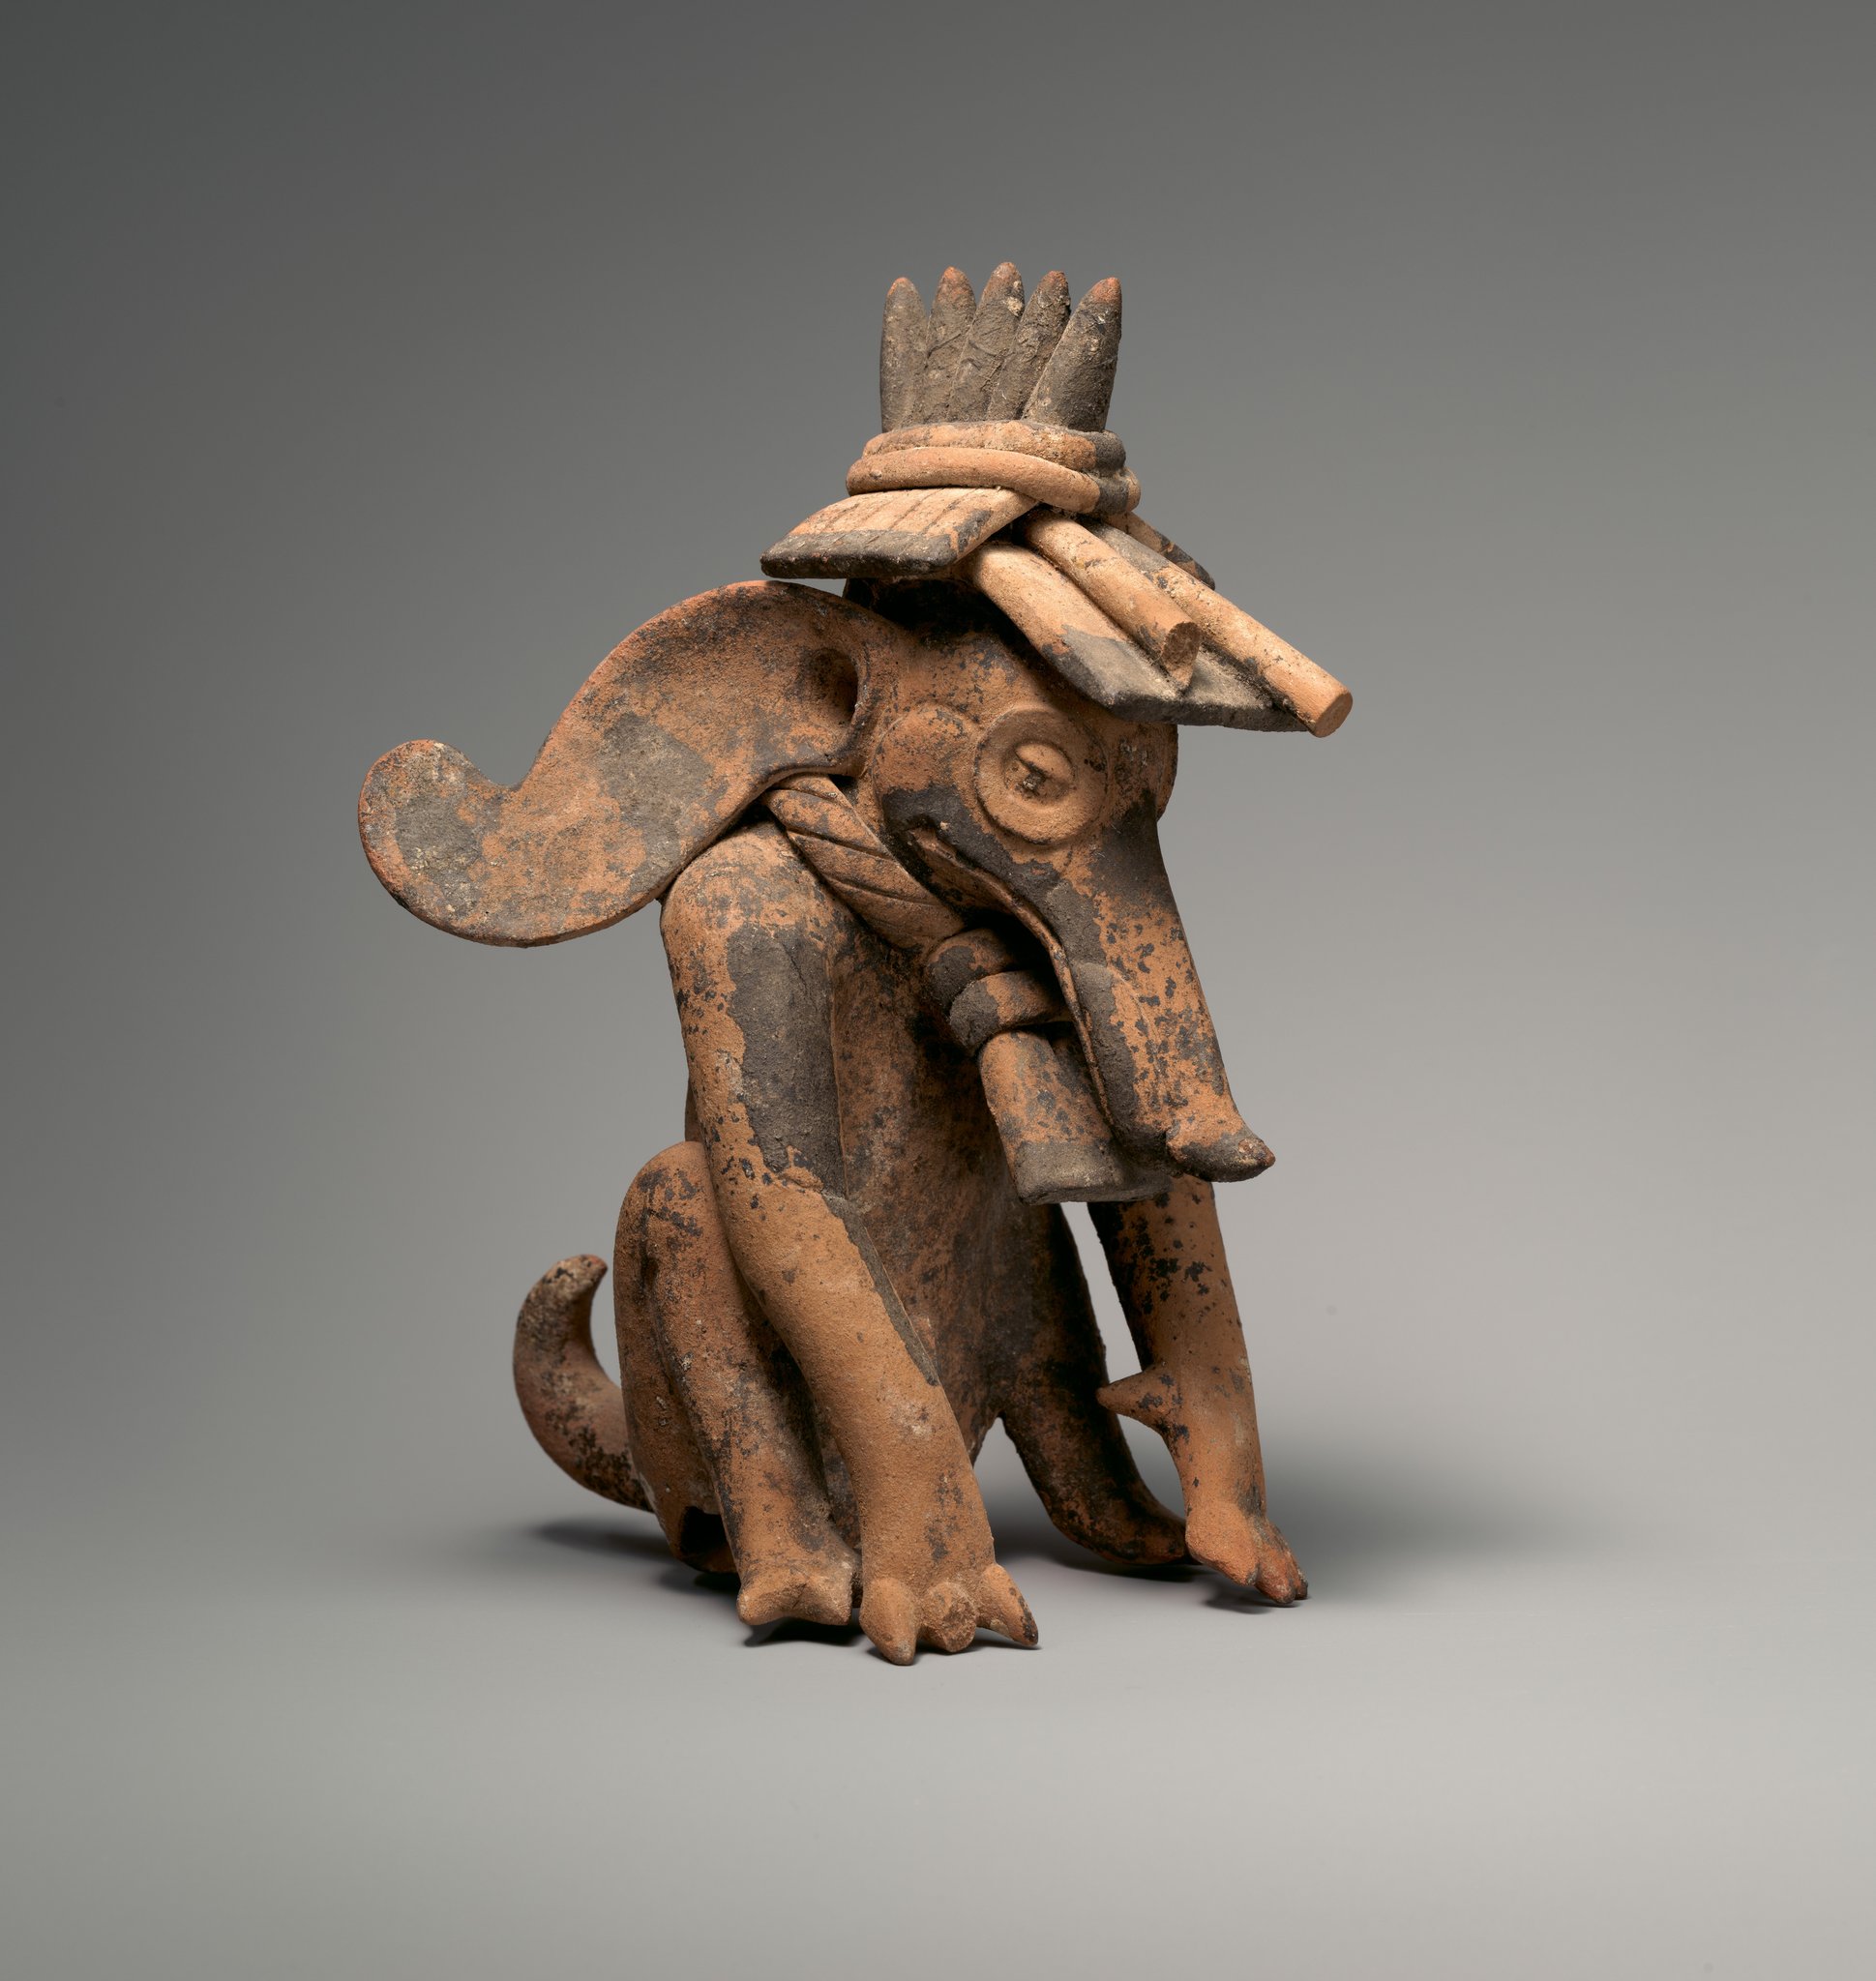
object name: figure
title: Masked Figure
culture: veracruz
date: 601-900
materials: ceramic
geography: mexico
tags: animals,masks